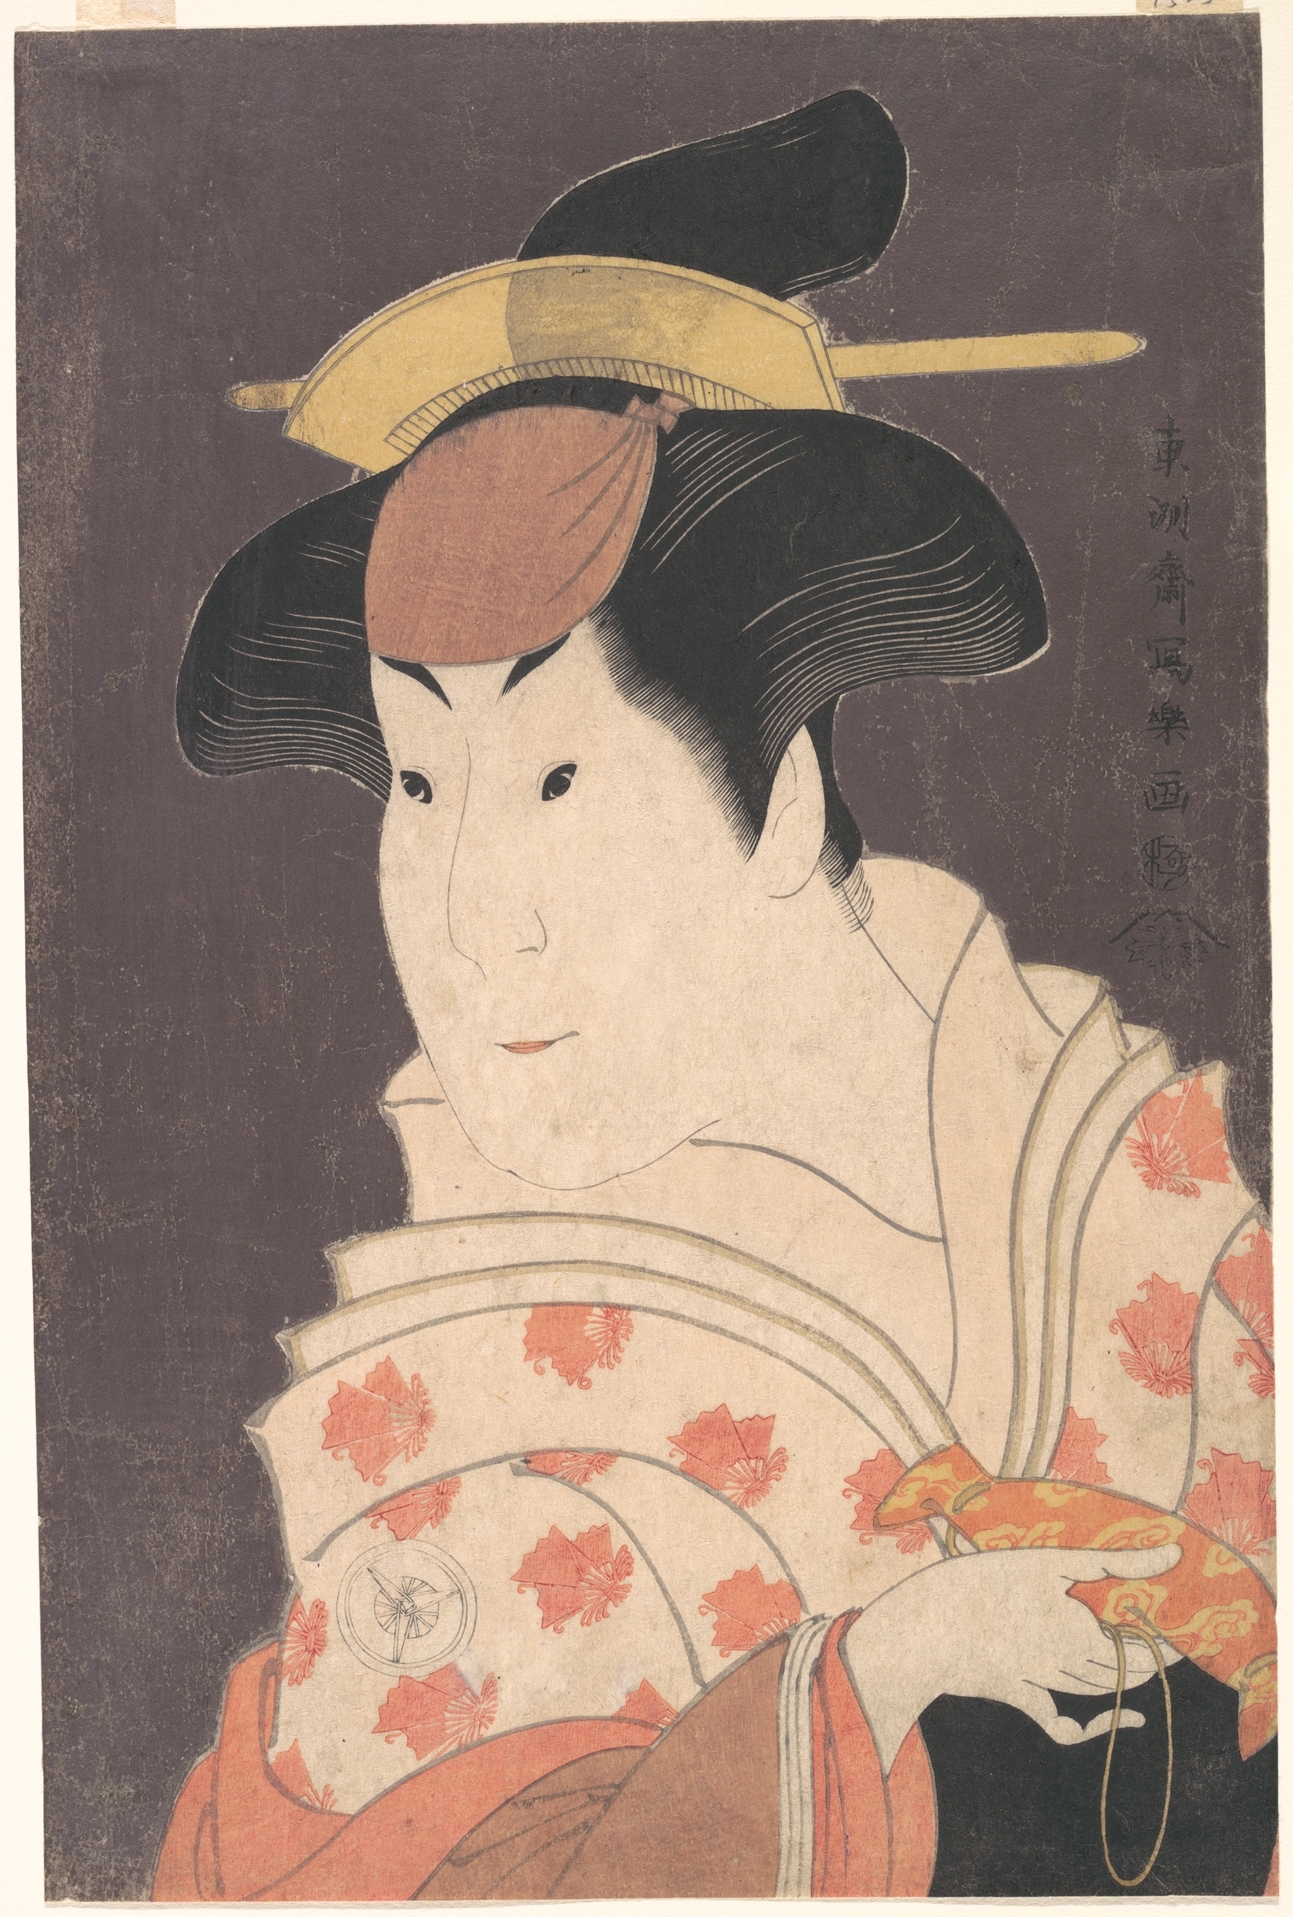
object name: print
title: Iwai Hanshirō IV as Shigenoi in the Play "Koinyōbō Somewake Tazuna"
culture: japanese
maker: tōshūsai sharaku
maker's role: artist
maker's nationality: japanese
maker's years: 1794-1795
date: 1794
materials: ink, mica, paper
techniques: woodblock print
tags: men,women,actors